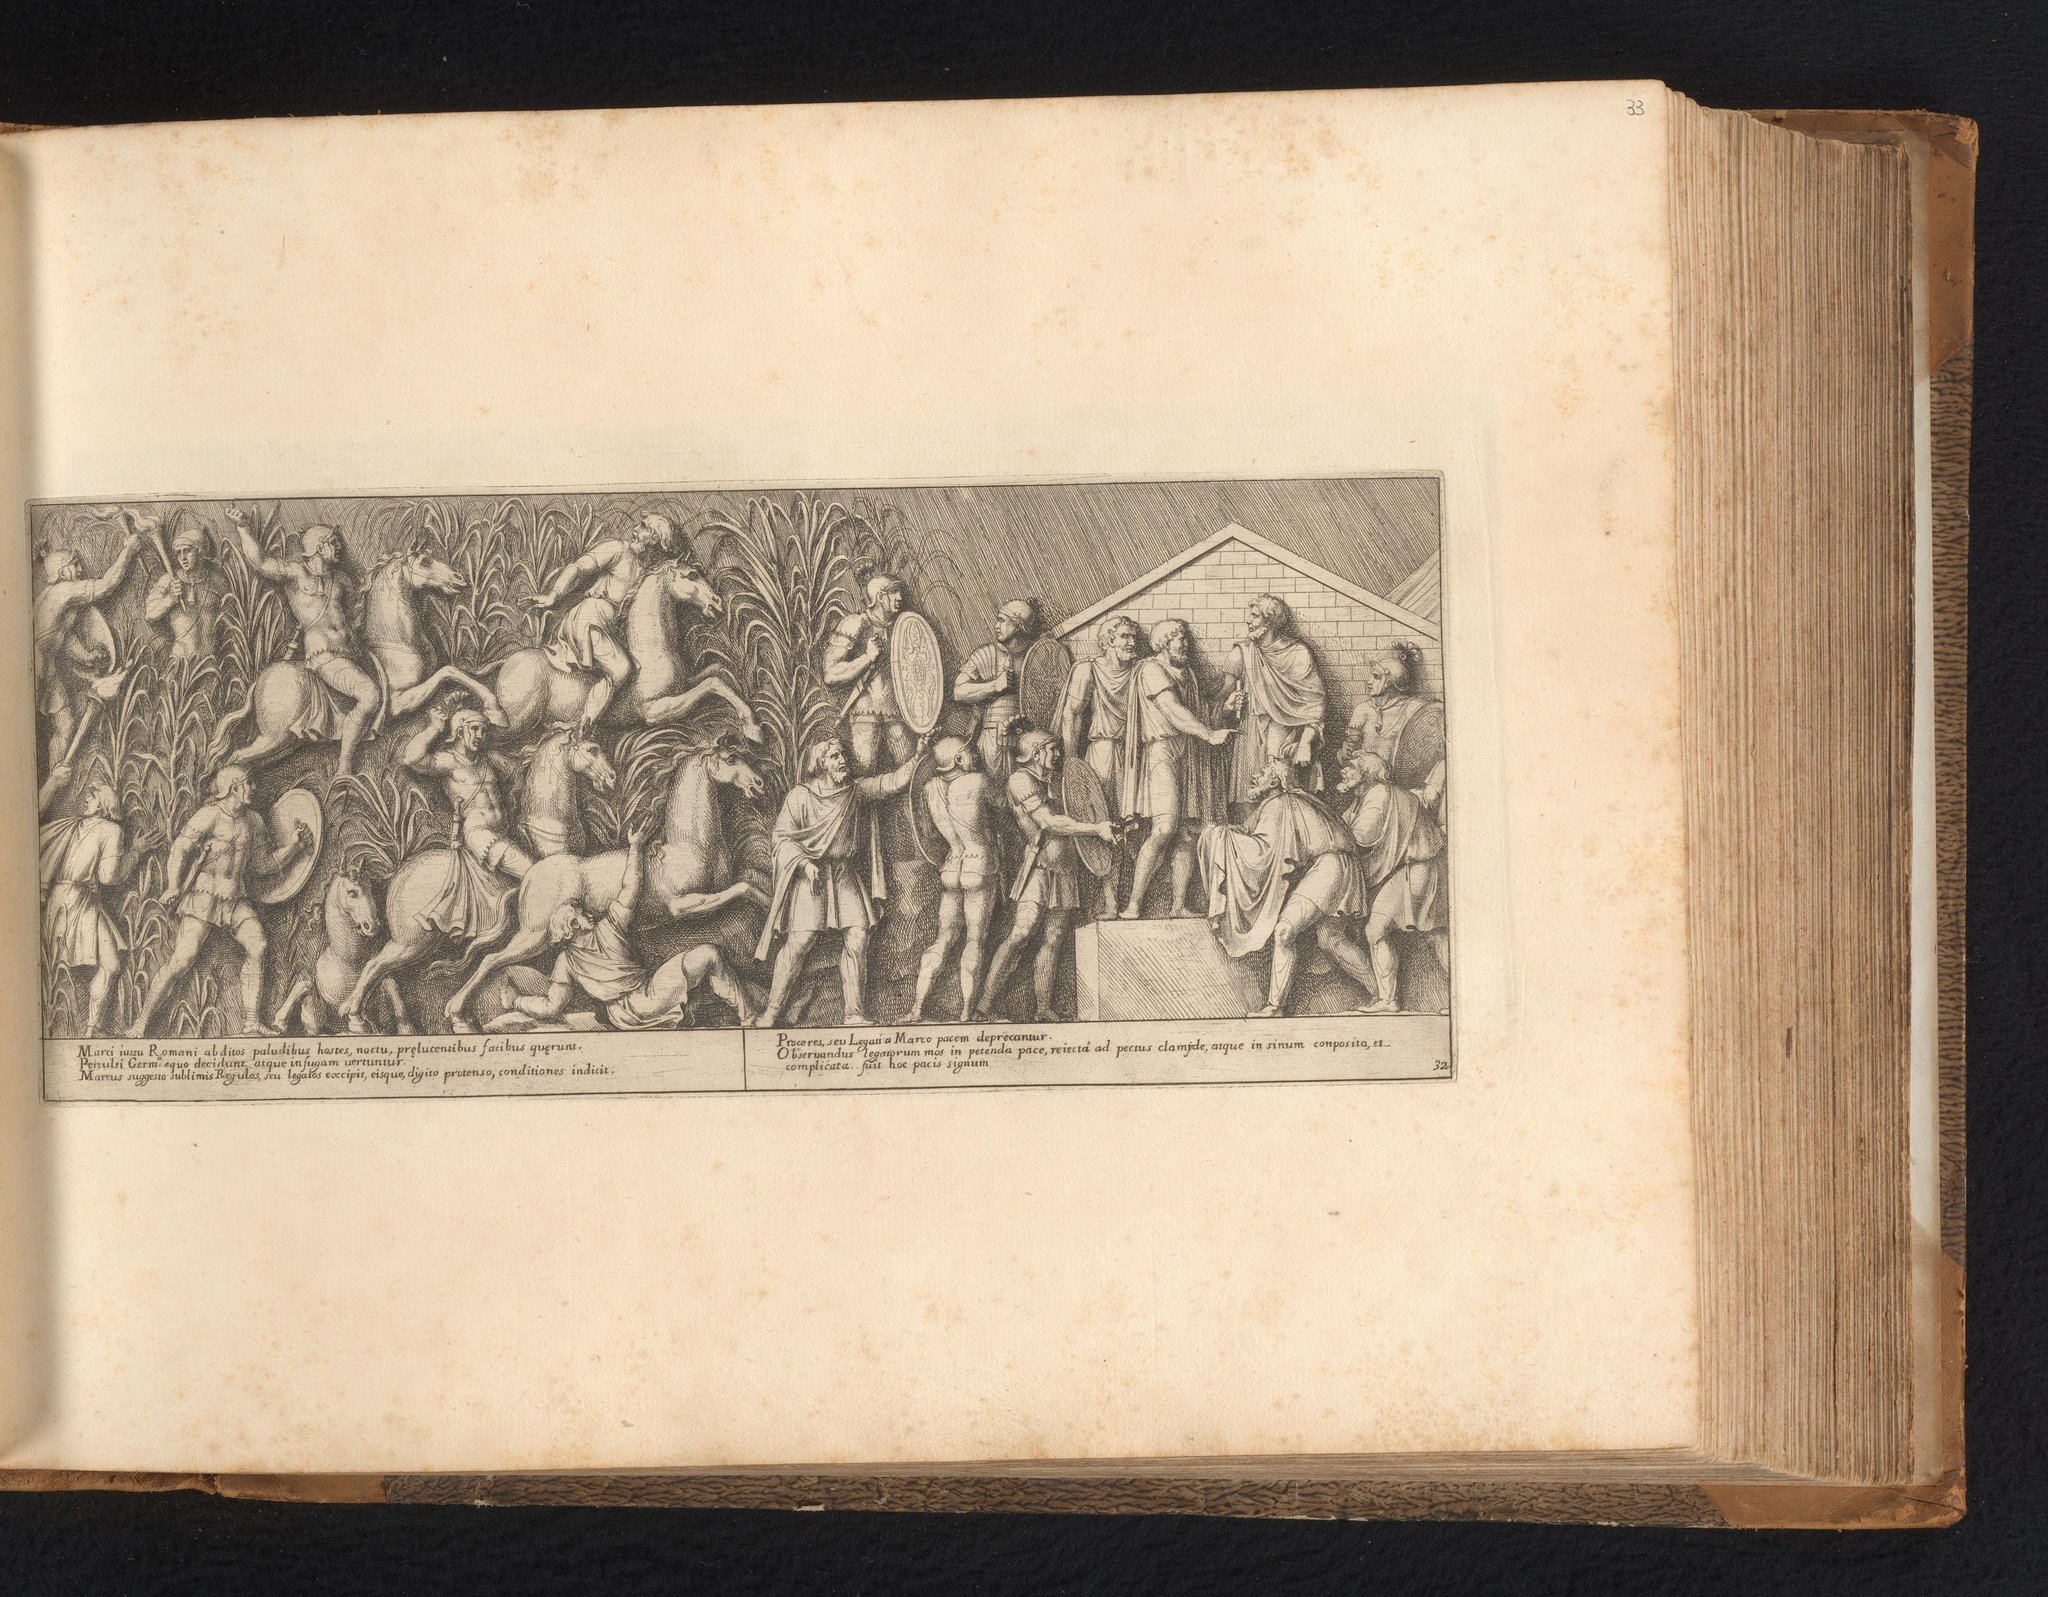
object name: album leaf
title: Zuil van Marcus Aurelius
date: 1672-1675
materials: paper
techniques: etching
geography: rome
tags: triumphal column with helical friezes, piece of sculpture, reproduction of a piece of sculpture, the soldier; the soldier's life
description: Detail van het spiraalvormige gebeeldhouwde fries op de Zuil van Marcus Aurelius te Rome. Het fries toont de oorlog tussen het Romeinse leger van keizer Marcus Aurelius en de Germaanse stammen der Marcomannen en Quaden en de oorlog tegen de Sarmaten die vanuit het huidige Iran Hongarije waren binnengevallen. Tekst in de ondermarge. Prent maakt deel uit van een album.